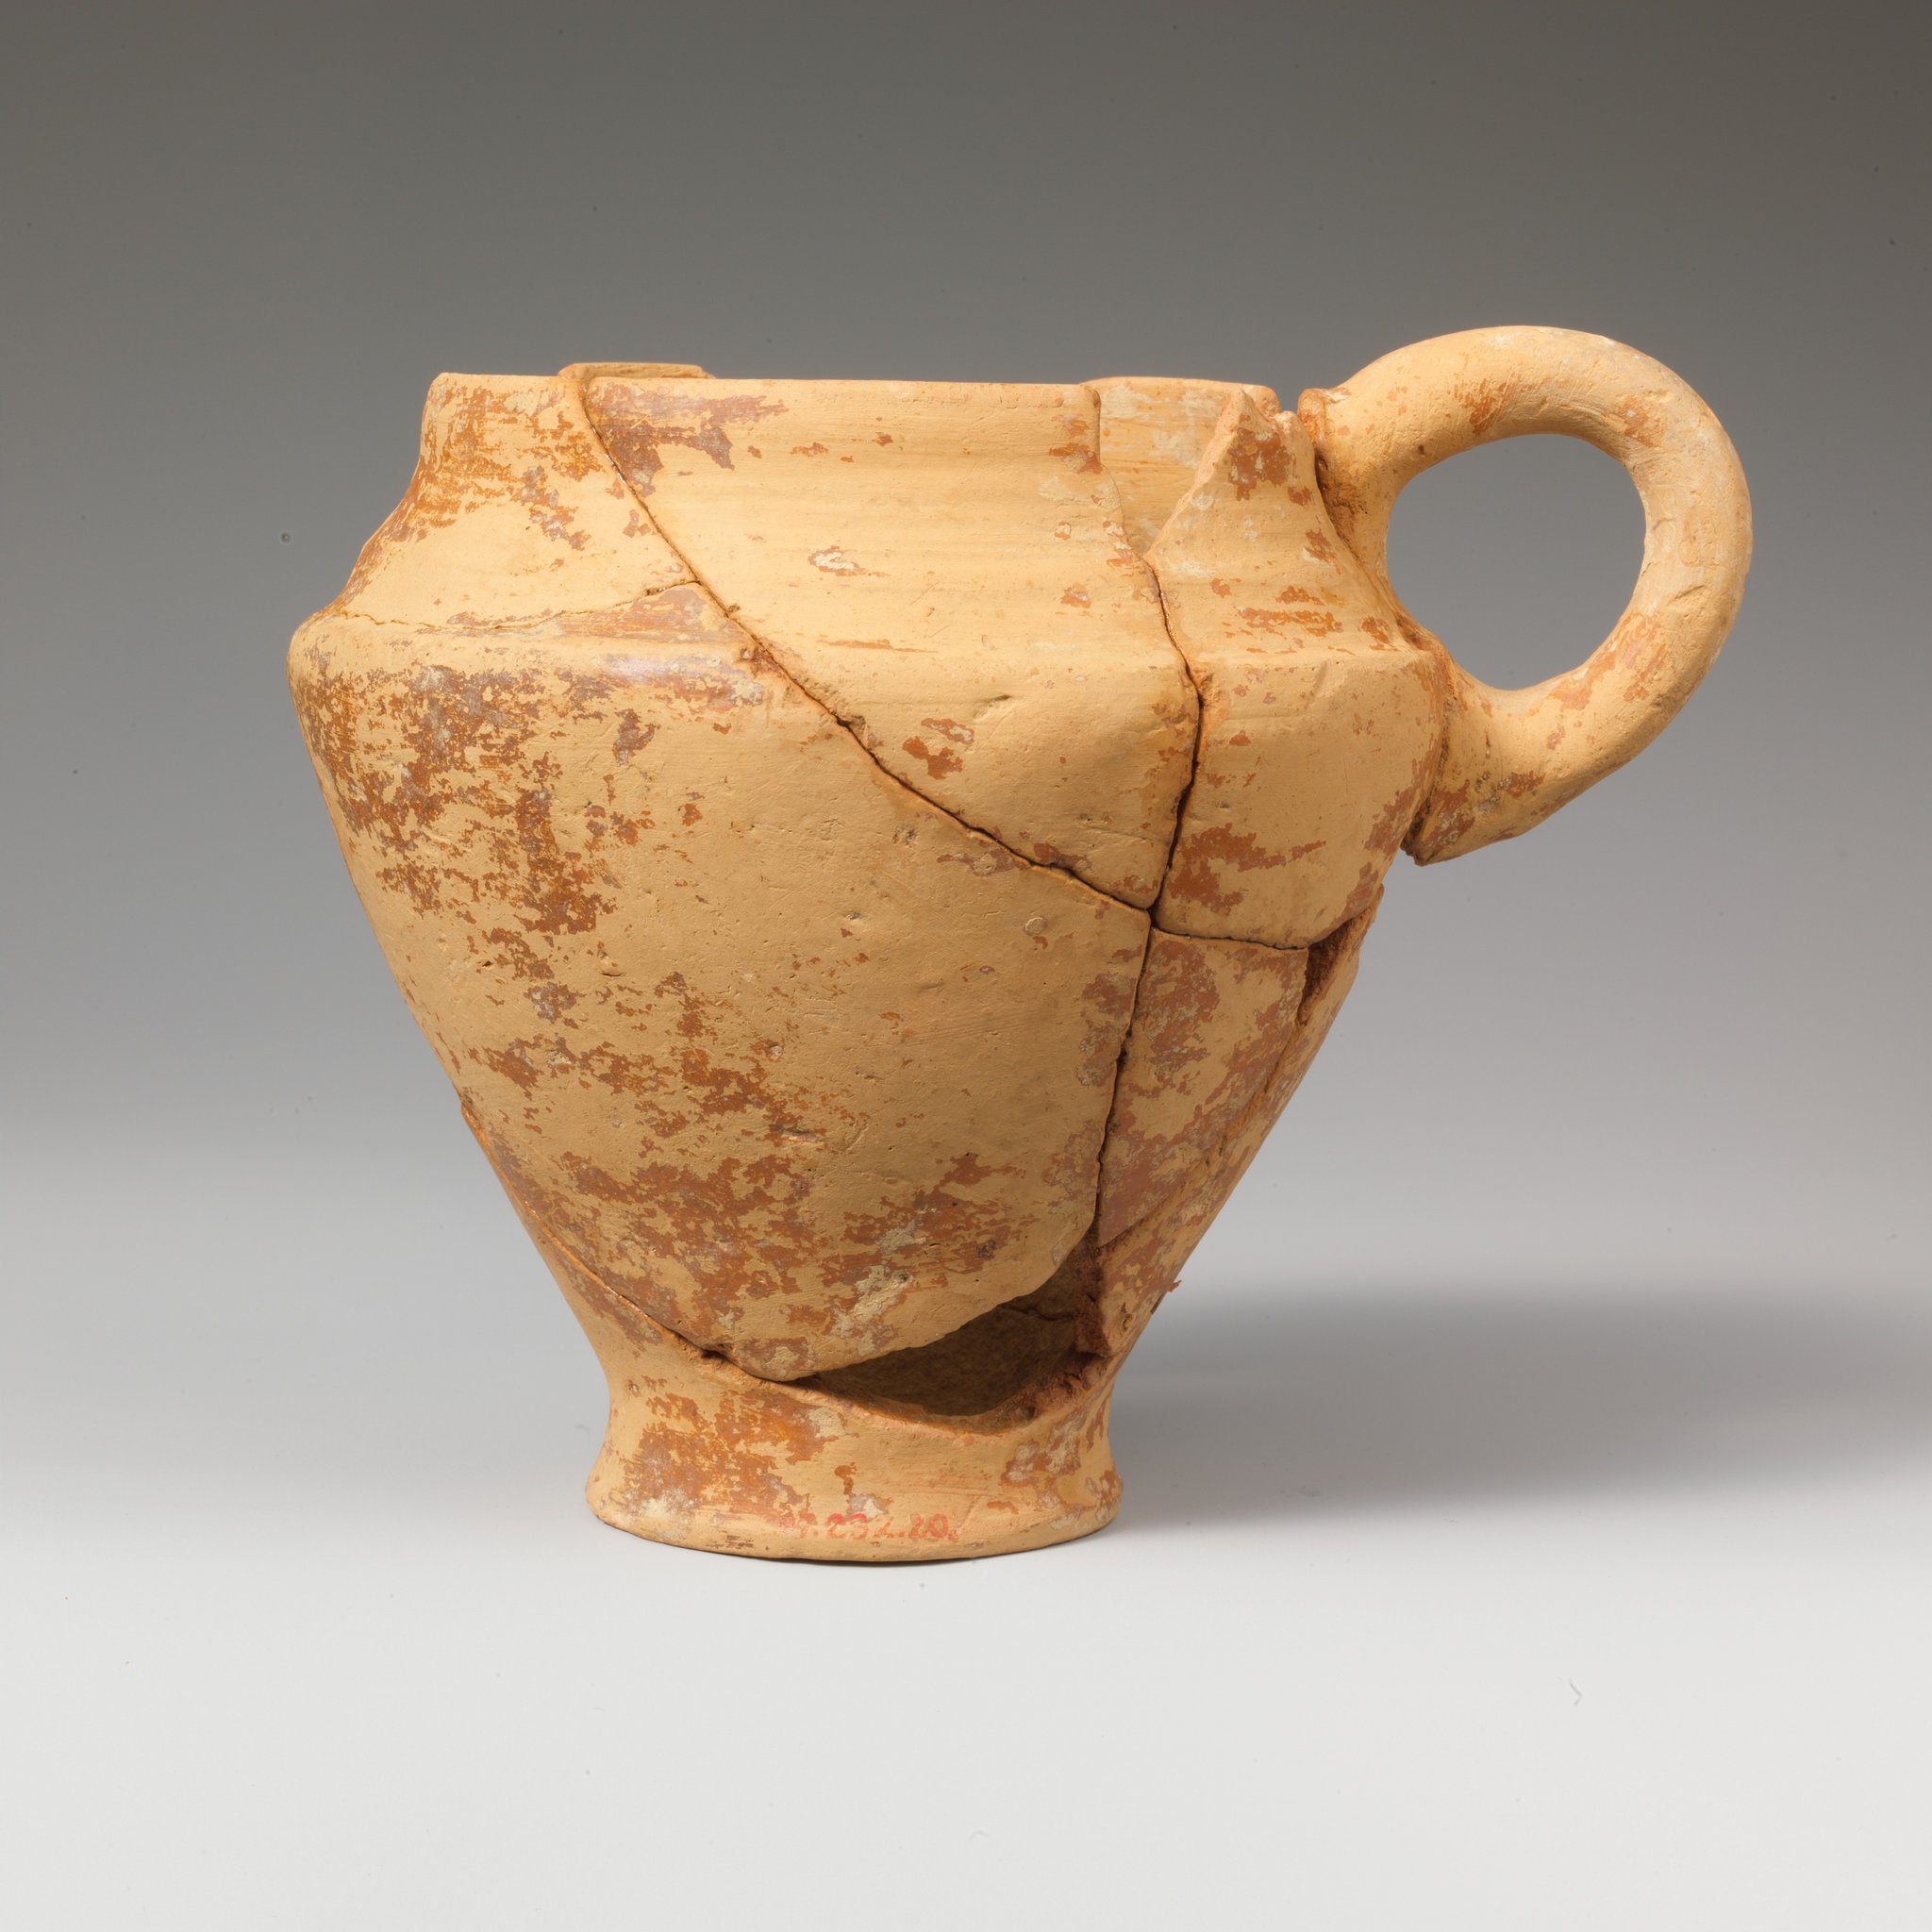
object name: cup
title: Terracotta carinated bridge-spouted jug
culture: minoan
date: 1900-1750 BCE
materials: terracotta